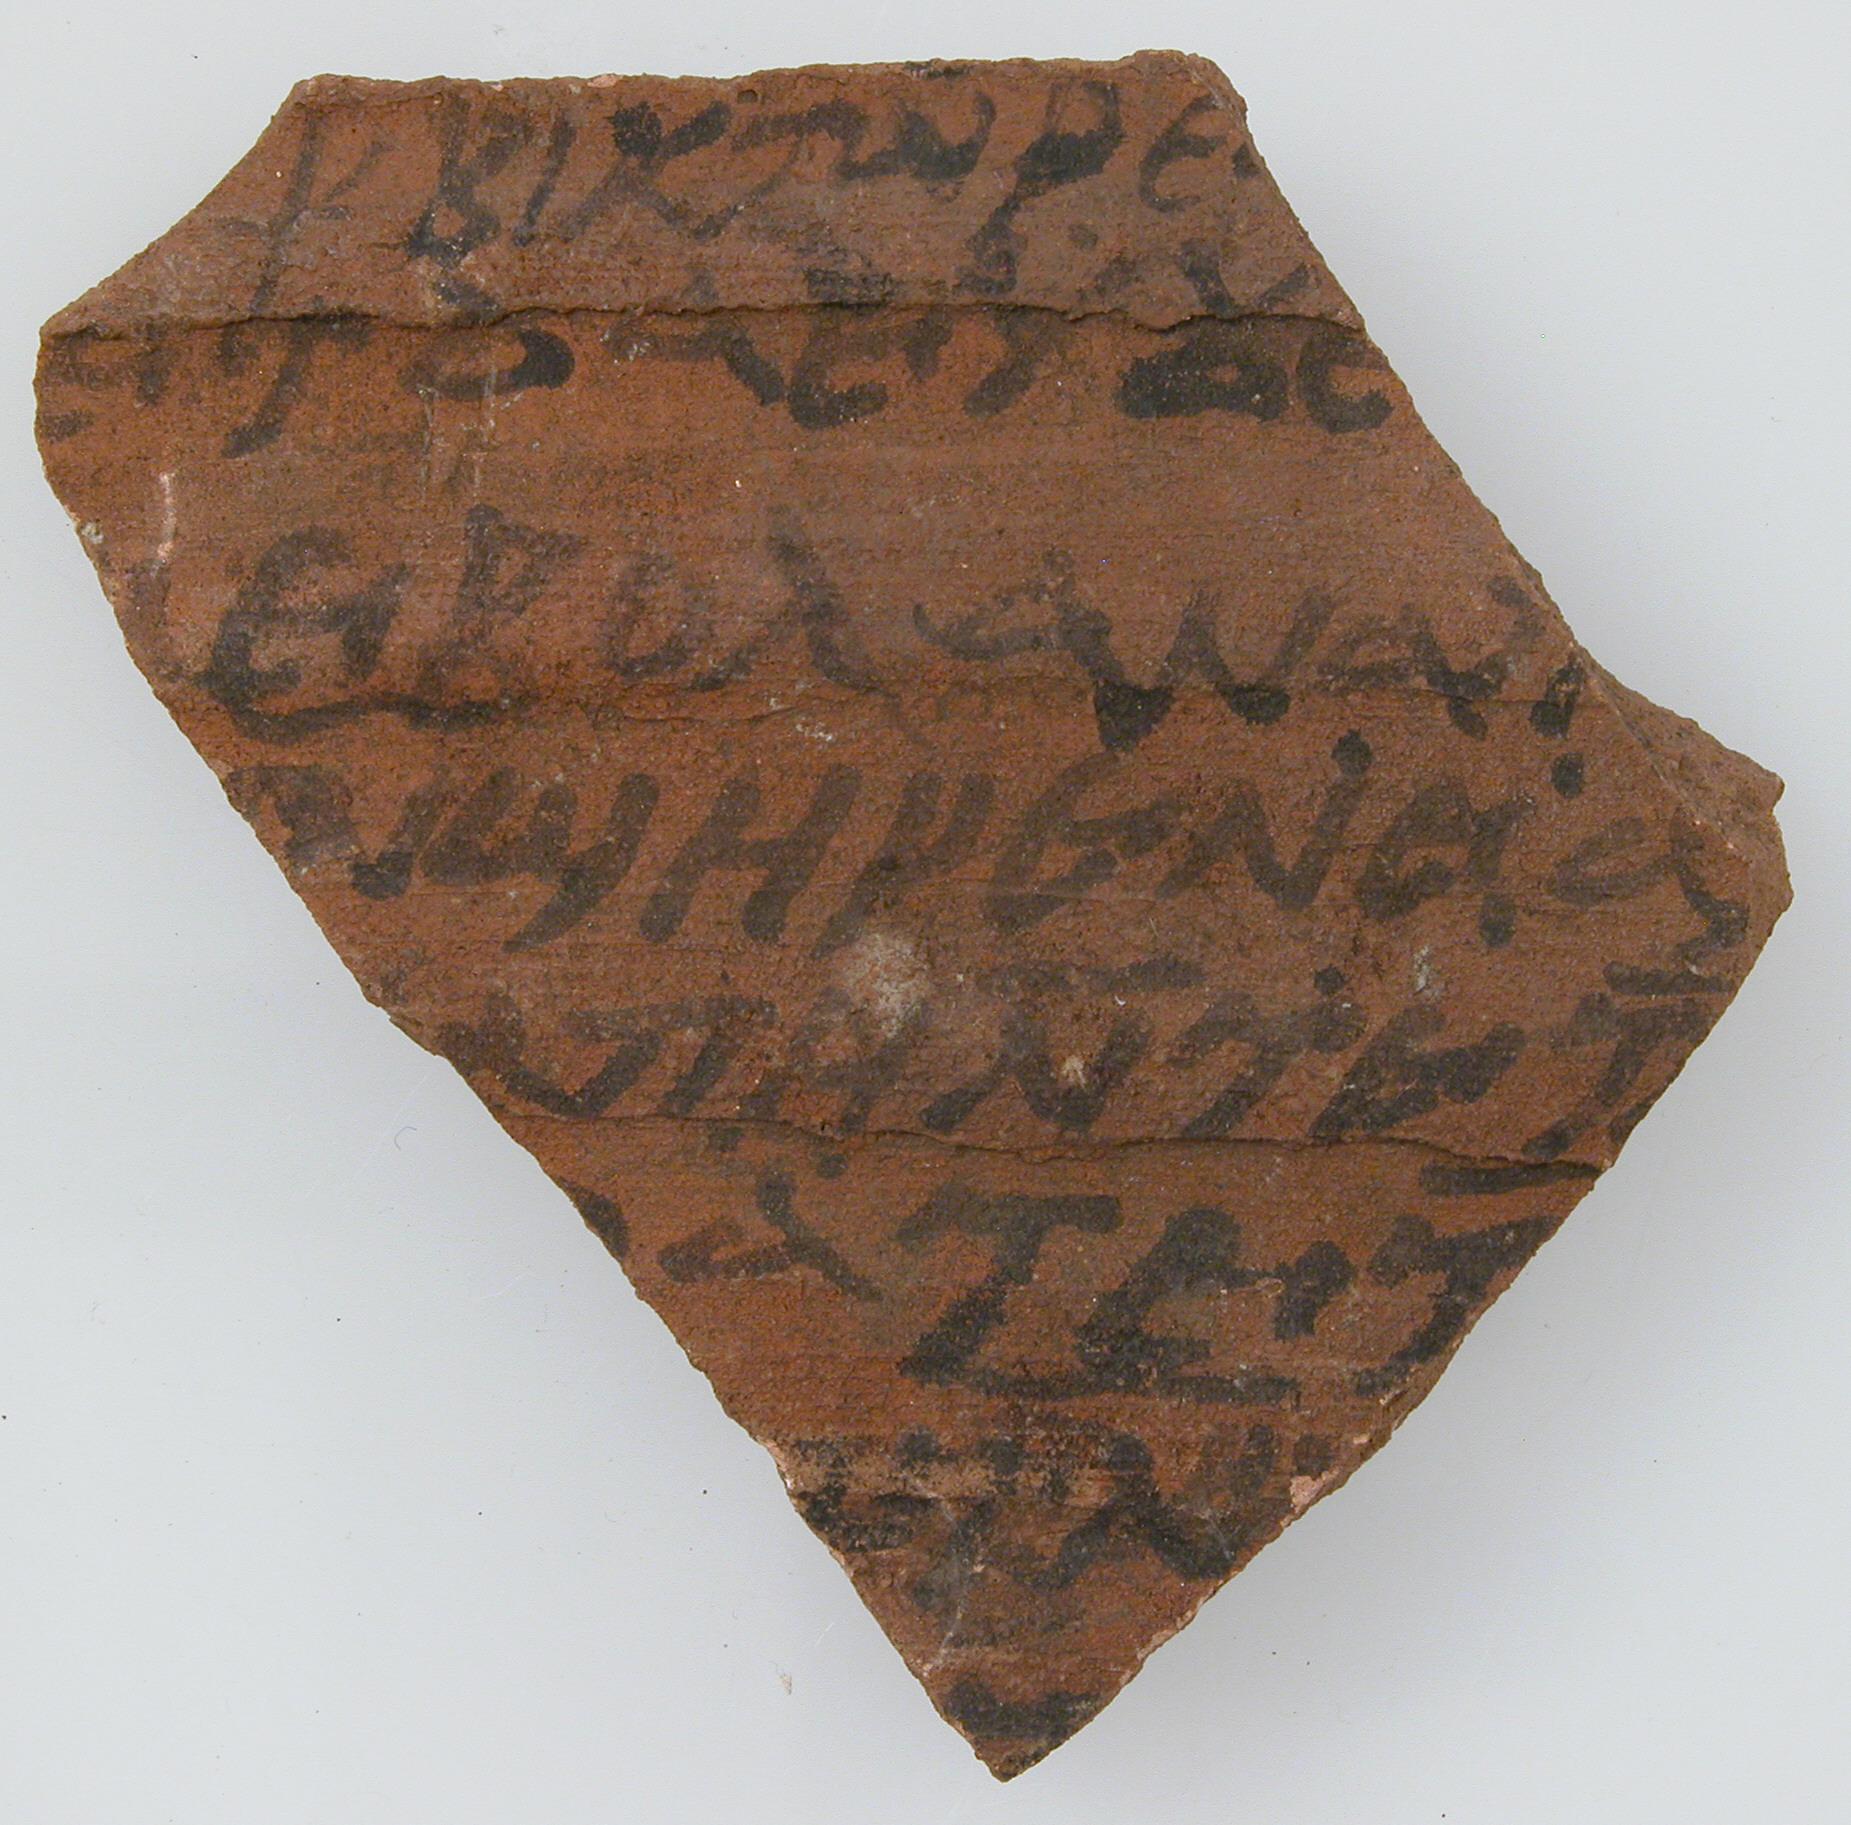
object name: ostrakon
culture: coptic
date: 601-700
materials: ink, pottery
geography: egypt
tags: coptic